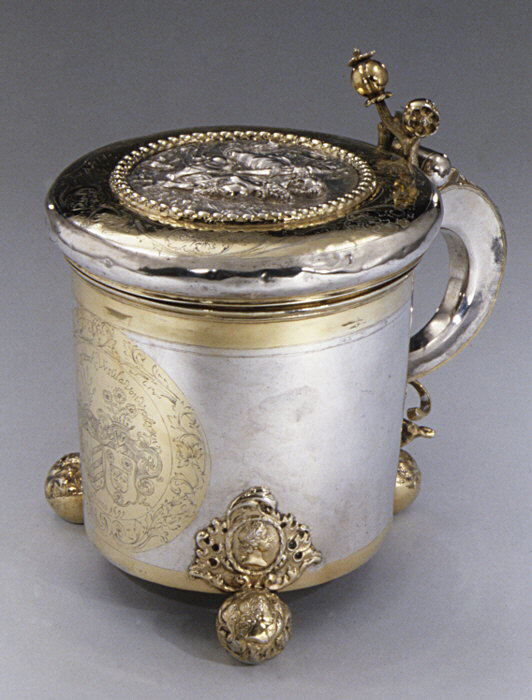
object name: tankard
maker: johann berend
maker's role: maker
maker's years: 1604-1704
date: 1700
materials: gilt, silver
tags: coat of arms